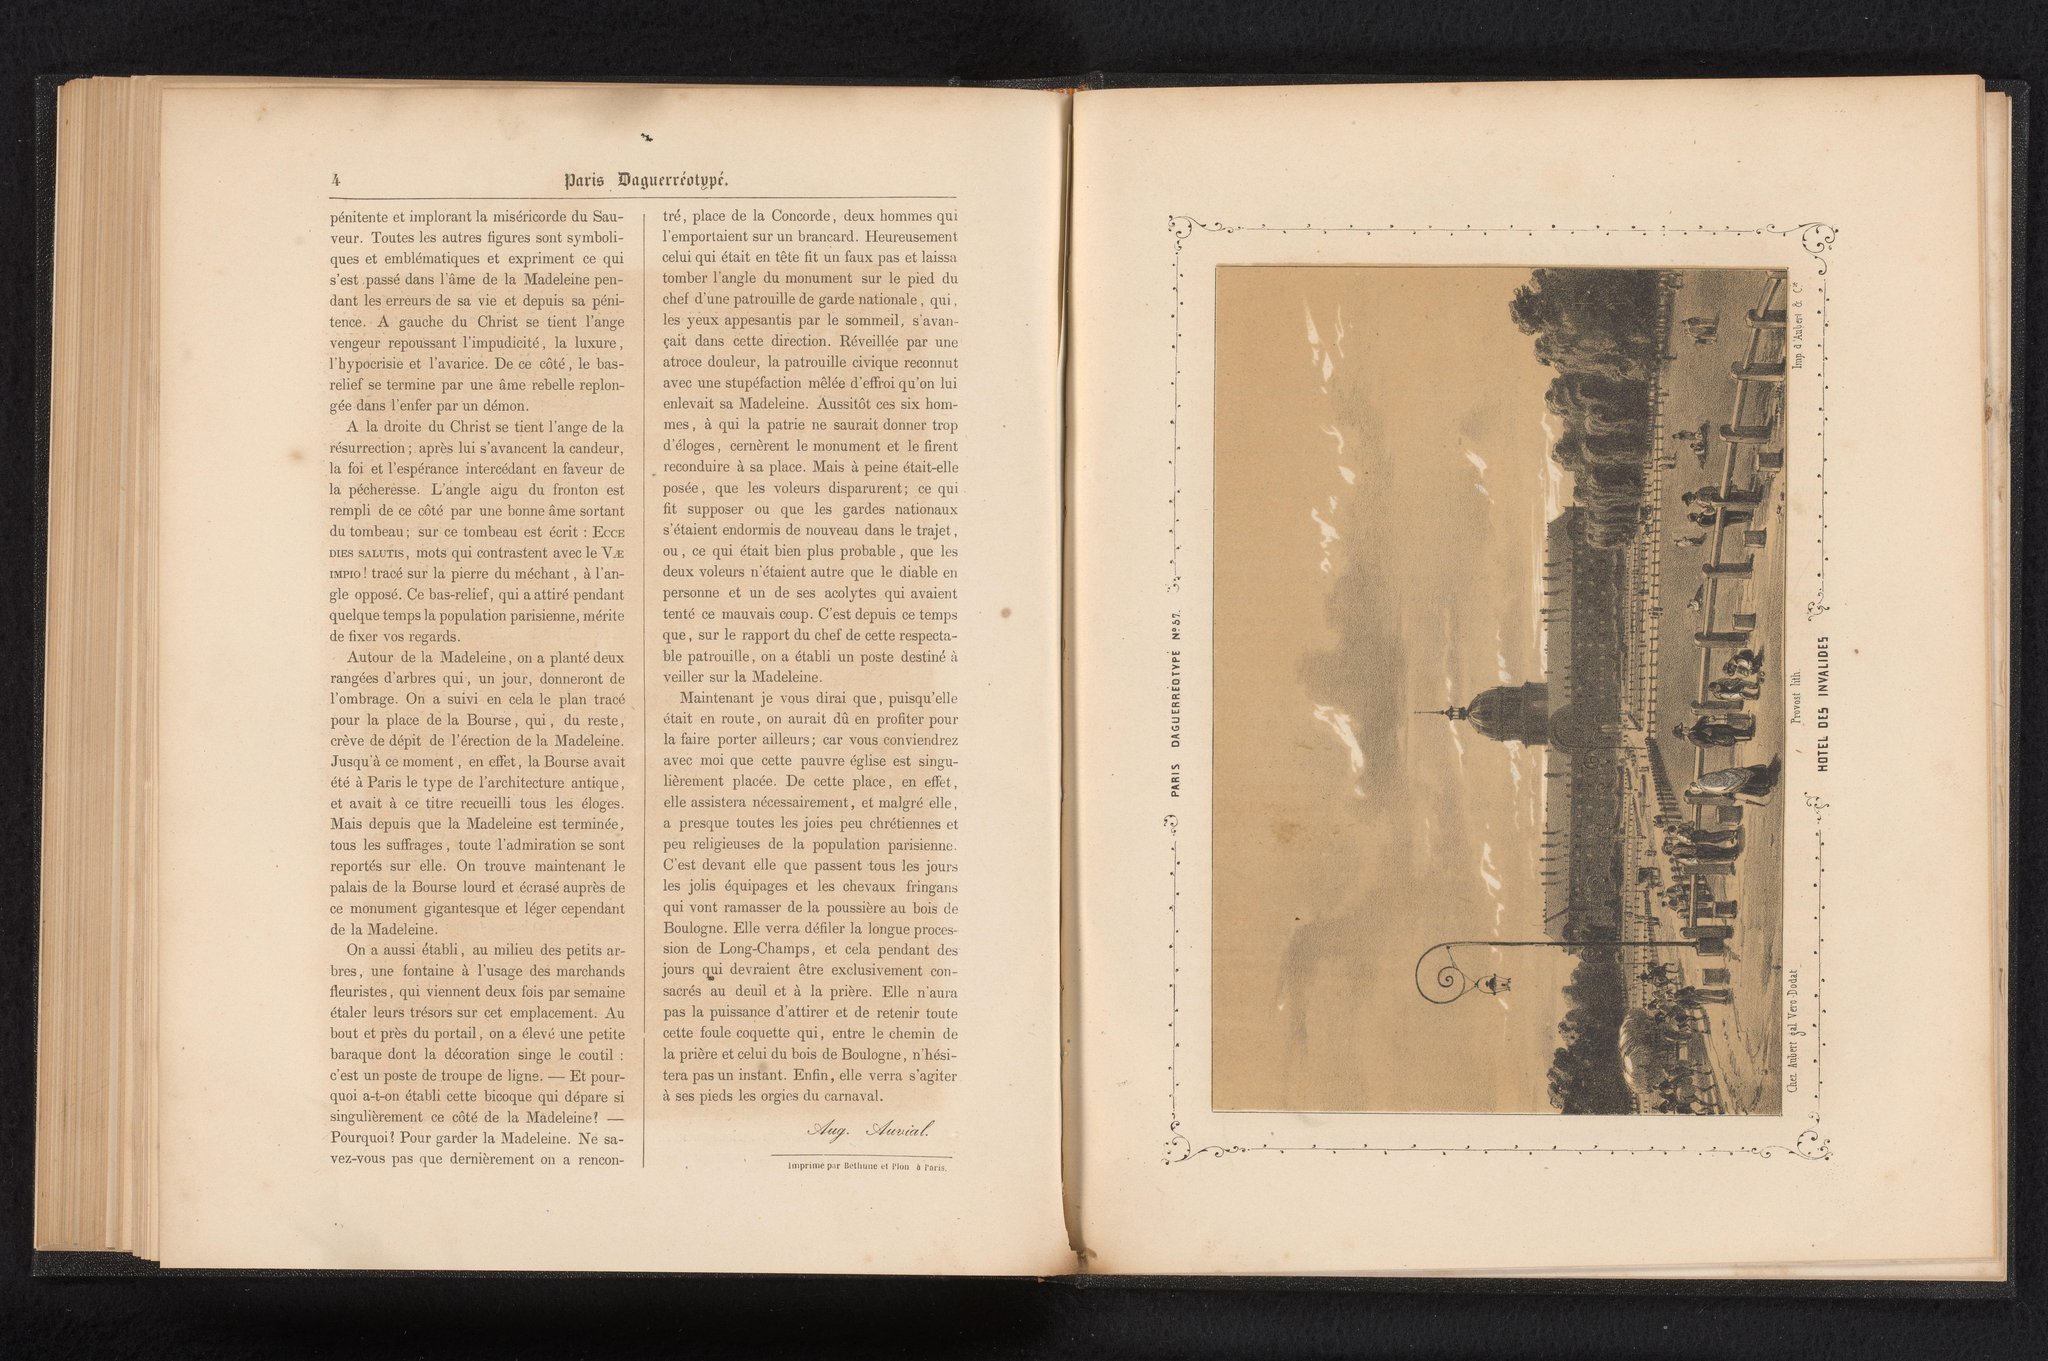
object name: page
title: Gezicht op het Hôtel des Invalides in Parijs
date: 1839-1840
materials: paper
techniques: tone lithography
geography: paris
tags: hospital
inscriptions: inscription: ‘PARIS DAGUERRÉOTYPÉ No. 57.’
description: Prent op tweehonderdzevenentwintigste ongenummerde pagina.